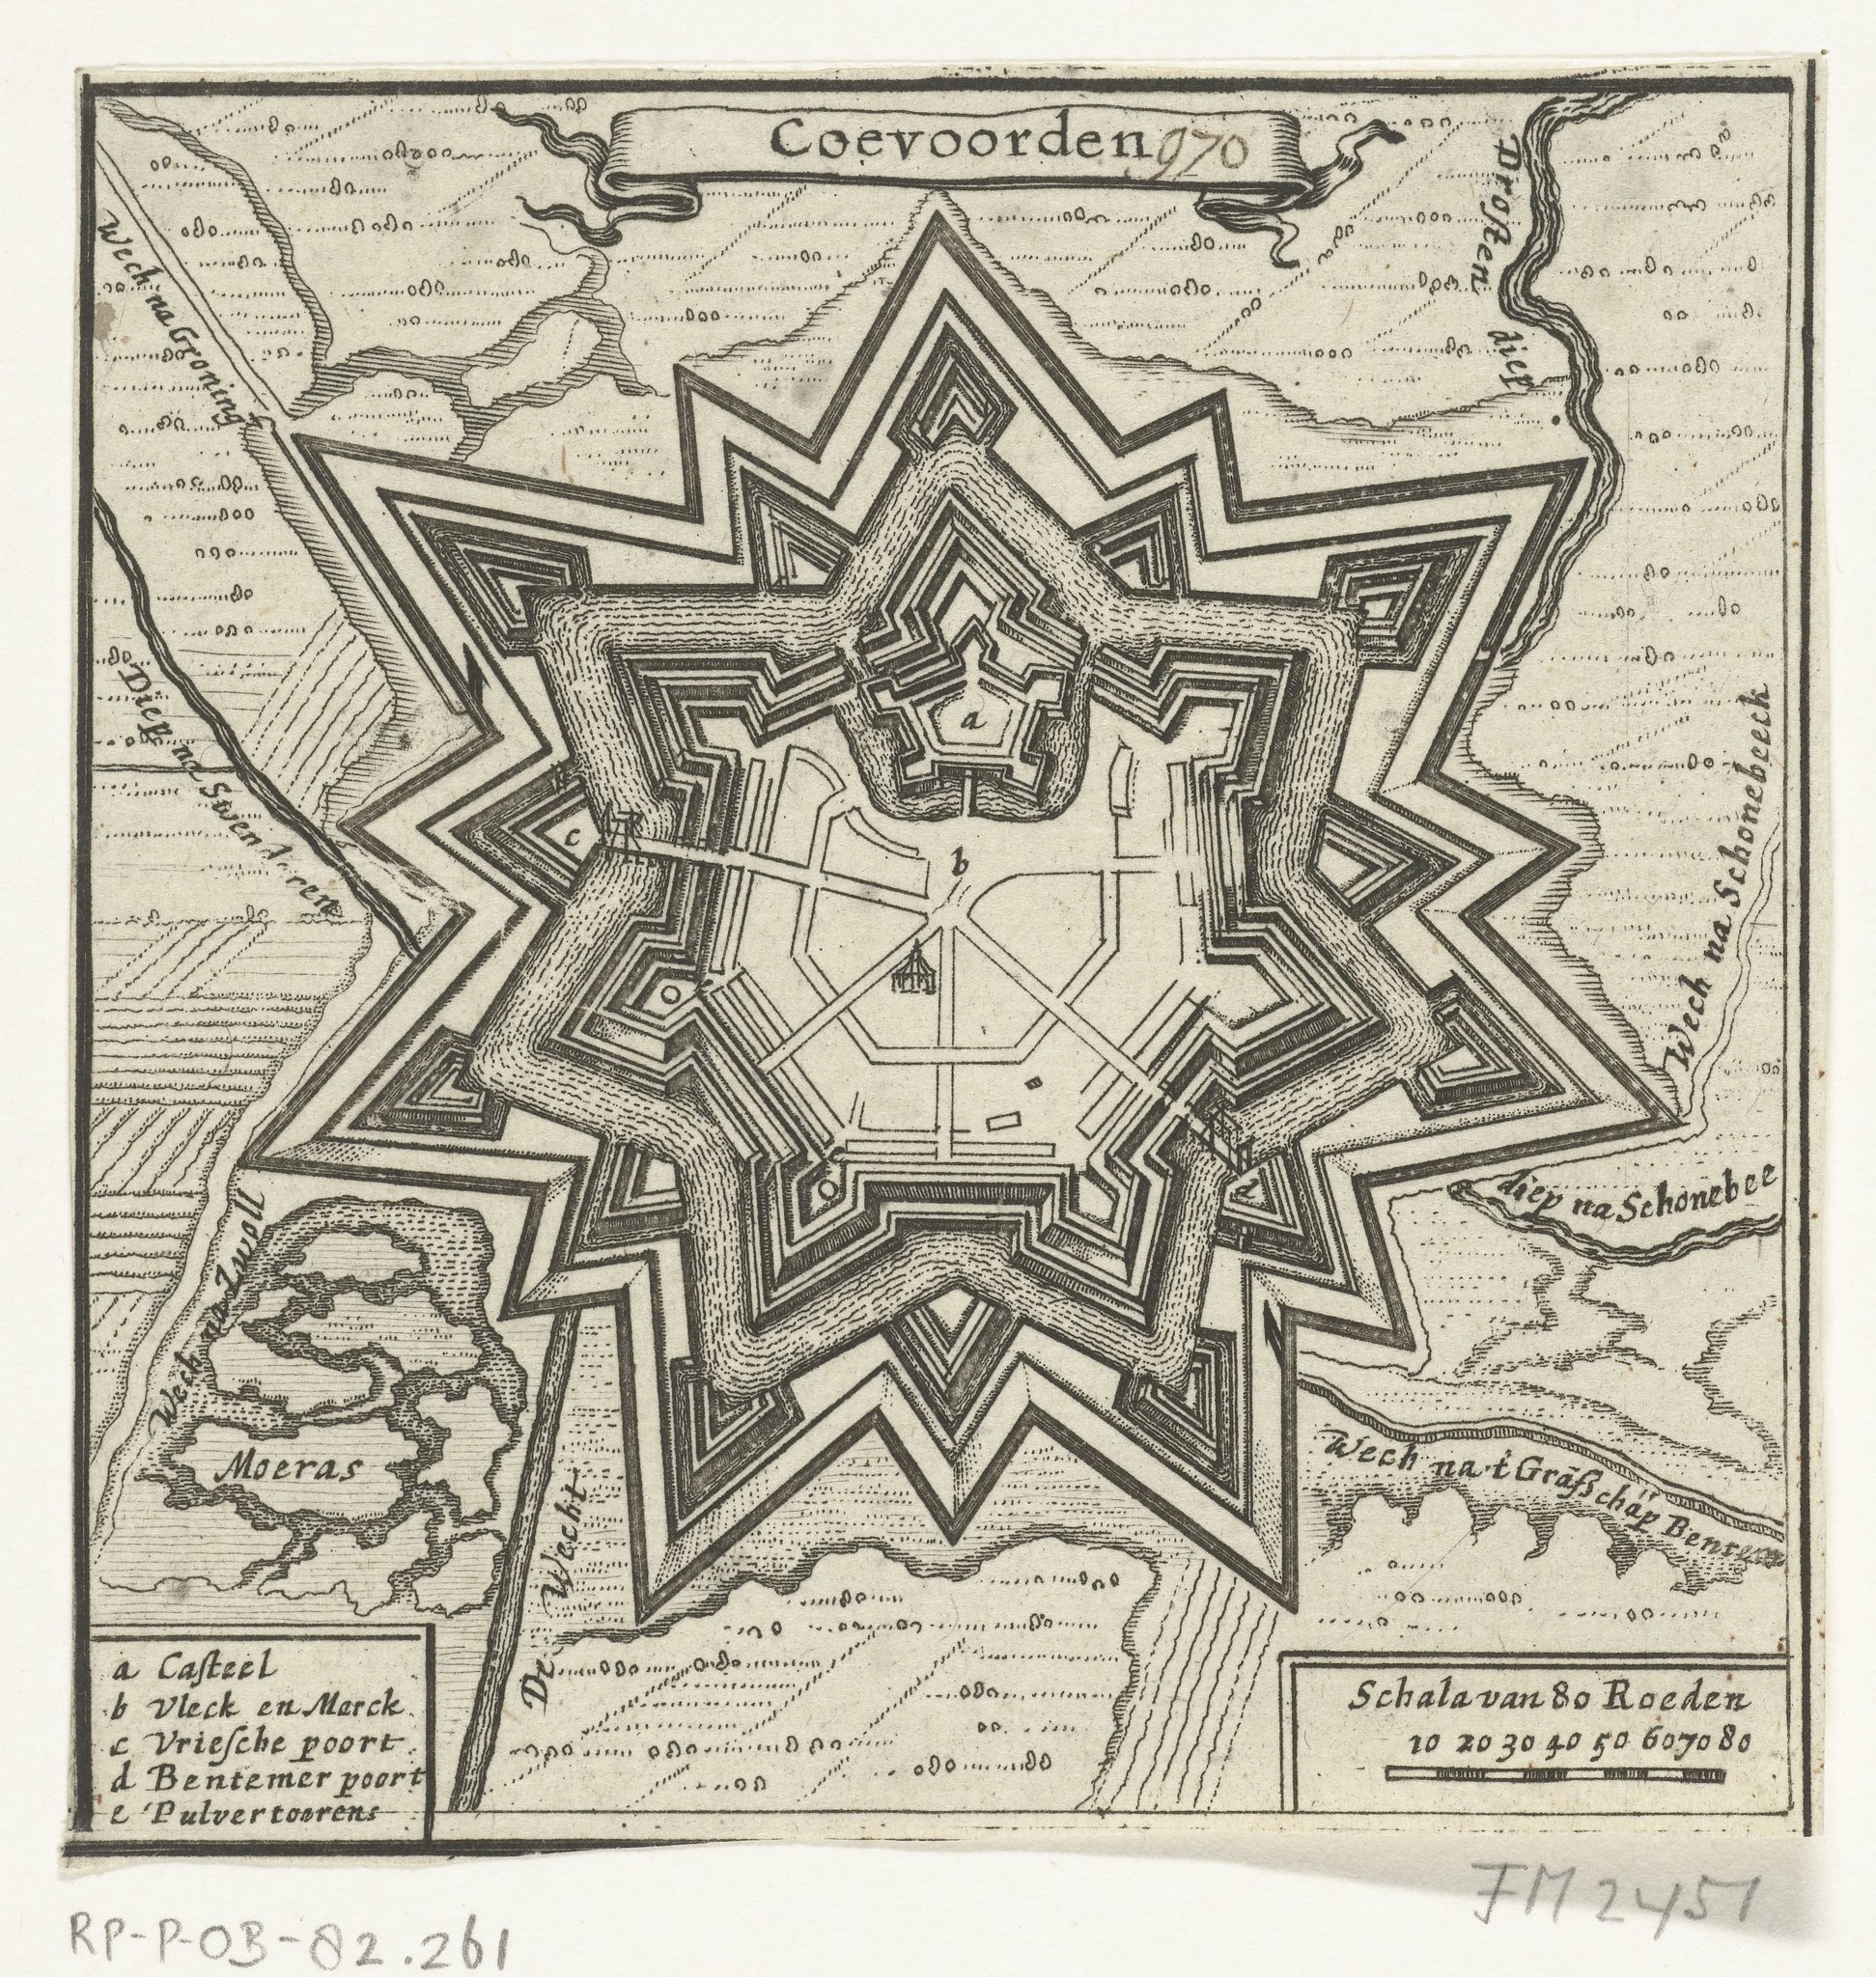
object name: print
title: Plattegrond van Coevorden, 1672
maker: Anonymous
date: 1673-1699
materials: paper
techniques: etching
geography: low countries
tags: maps of cities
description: Plattegrond van de vesting van Coevorden, op 30 december 1672 door de troepen onder leiding van Karl Rabenhaupt veroverd op de troepen van de bisschop van Munster. Linksonder de legenda a-e in het Nederlands.